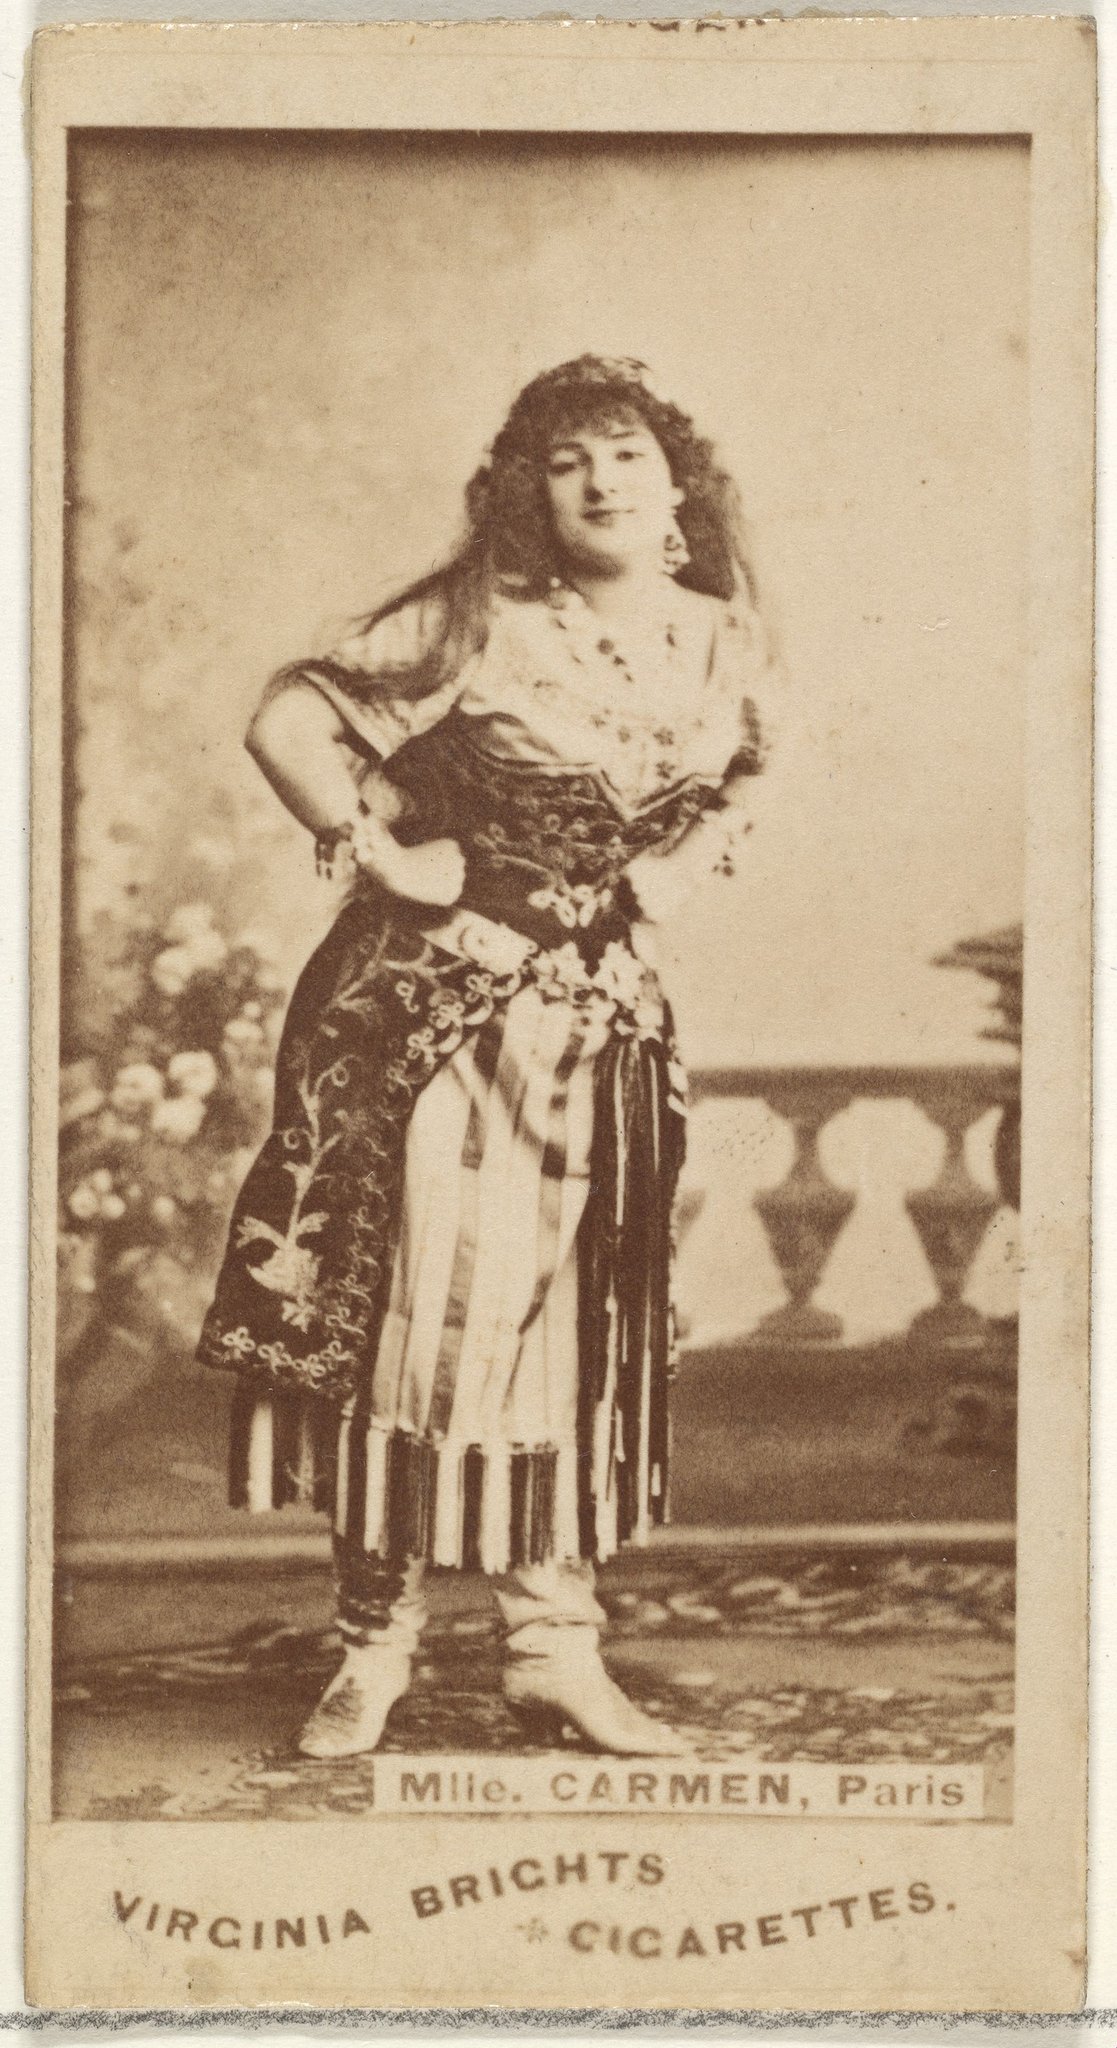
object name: photograph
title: Mlle. Carmen, Paris, from the Actors and Actresses series (N45, Type 1) for Virginia Brights Cigarettes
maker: allen & ginter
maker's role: publisher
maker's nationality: american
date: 1888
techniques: albumen silver print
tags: portraits,women,actresses